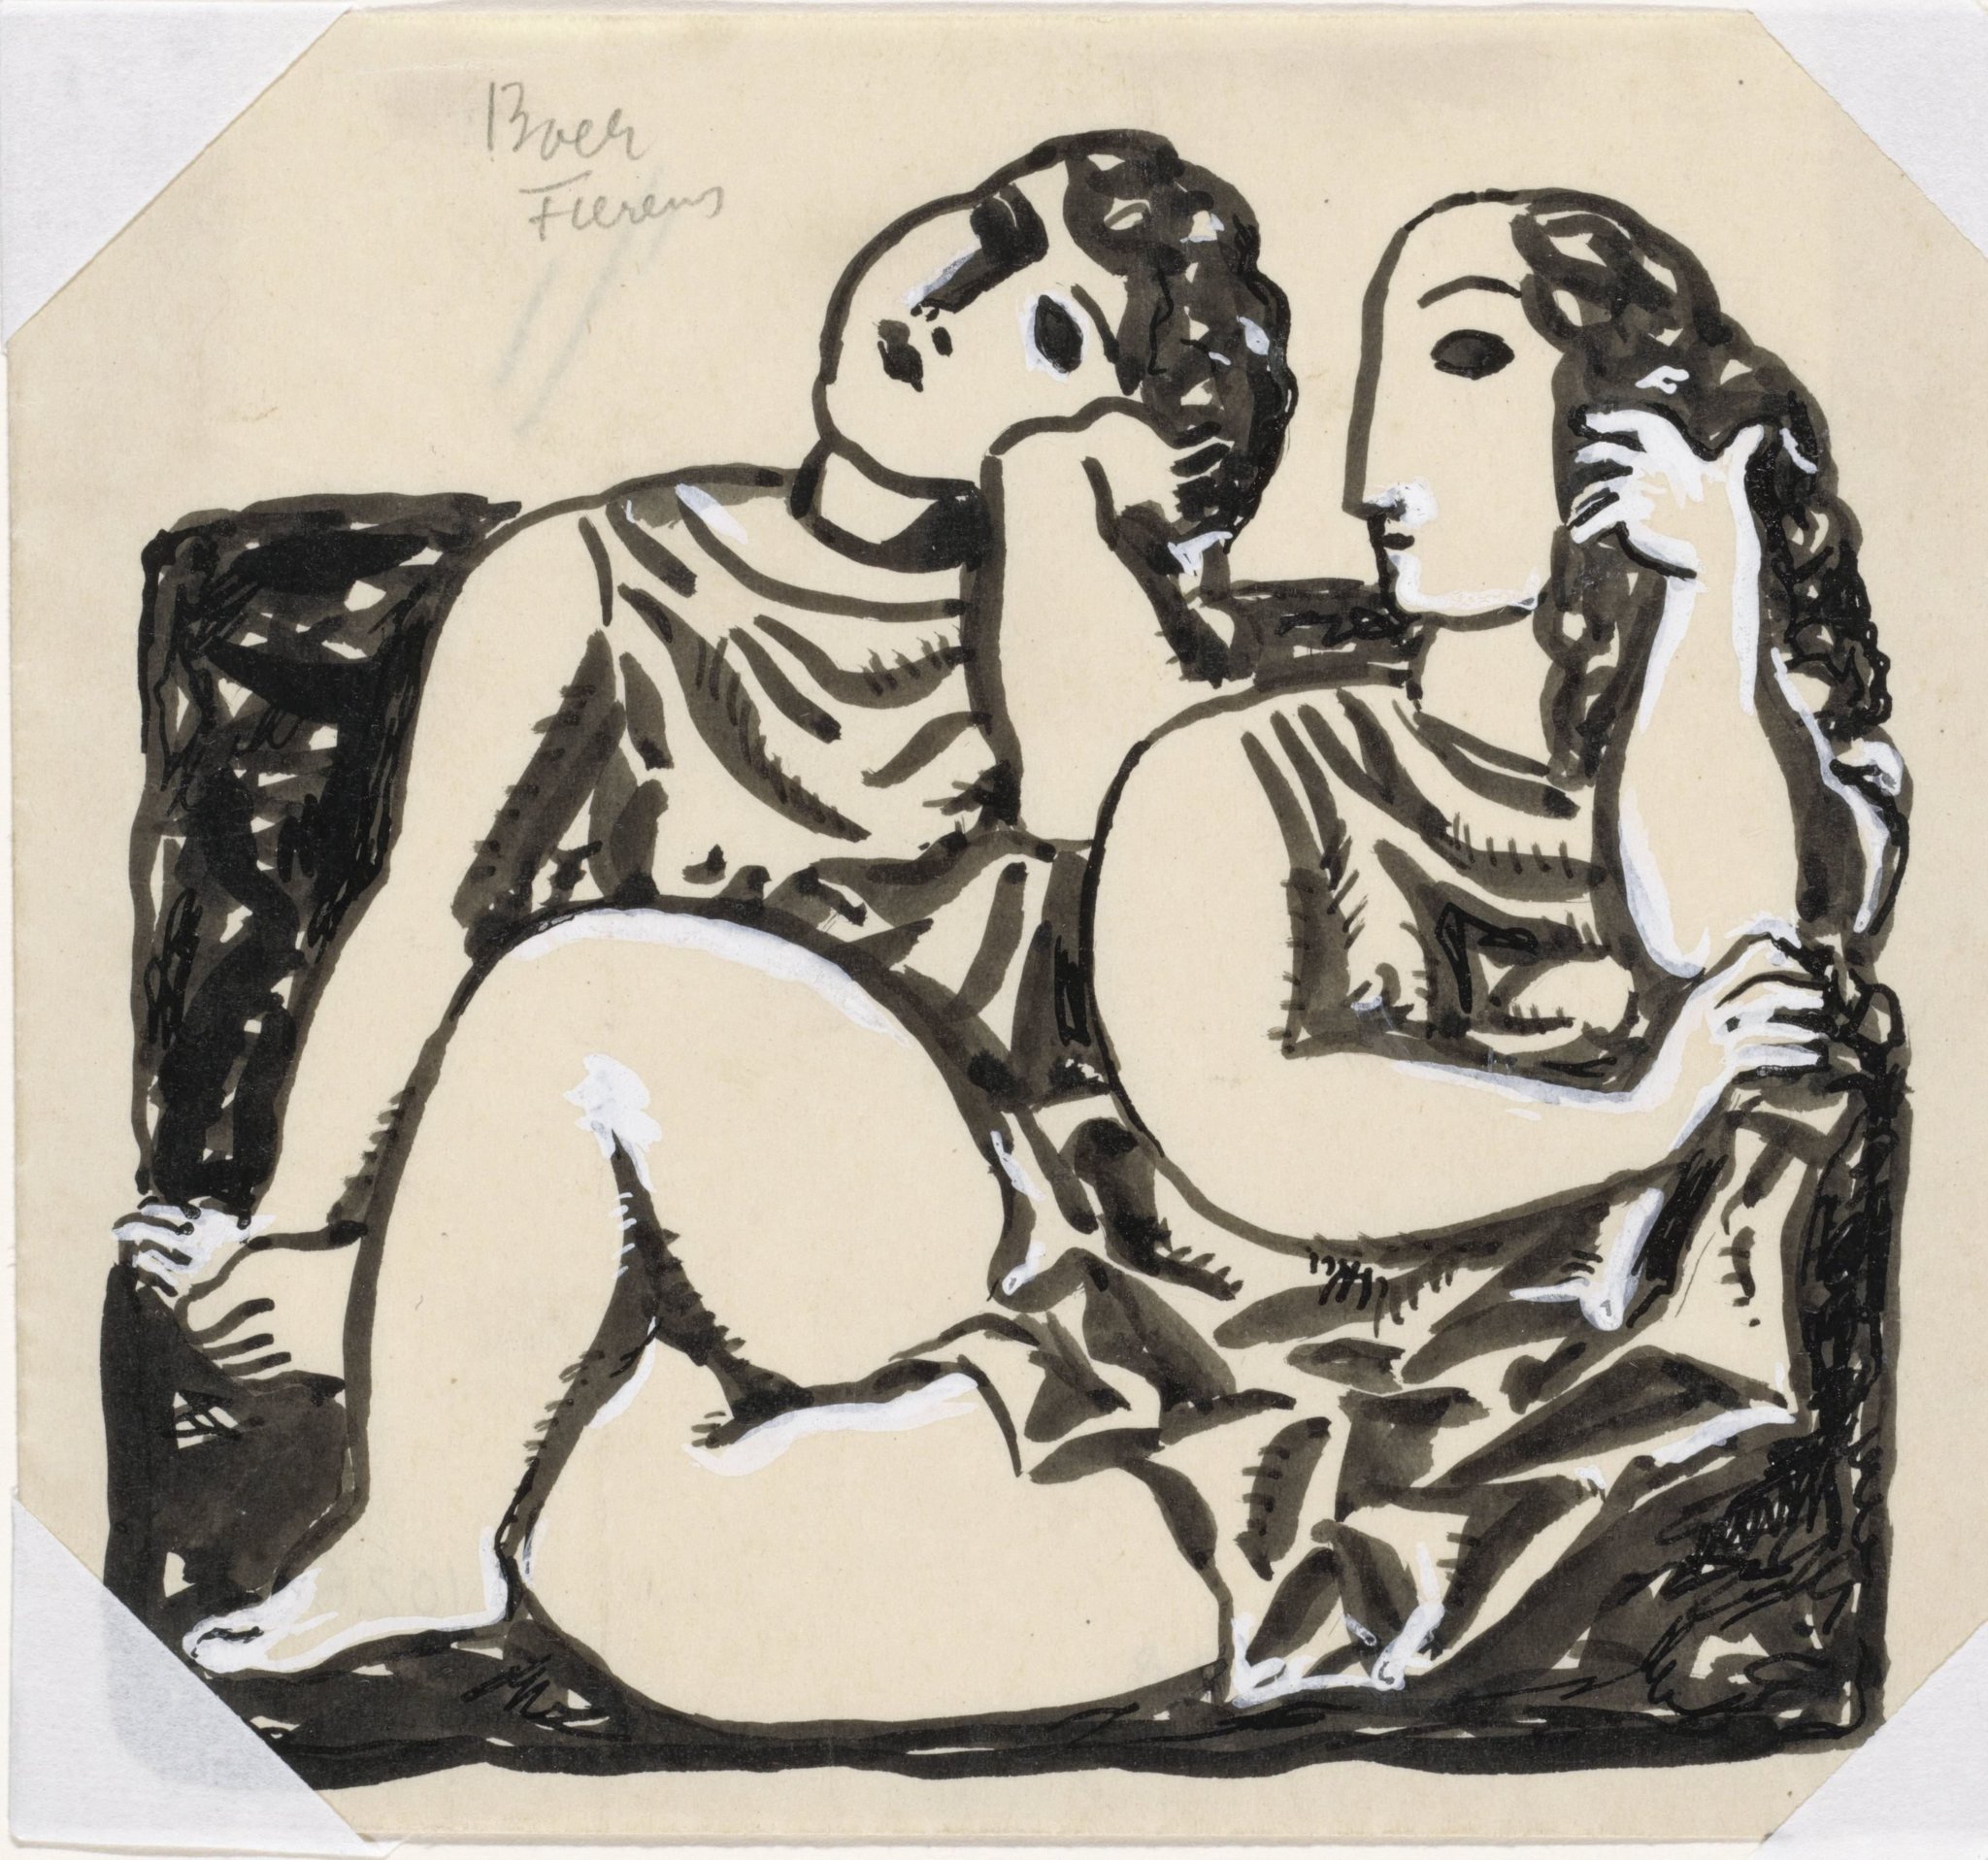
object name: drawing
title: Zonder titel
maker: leo gestel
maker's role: draughtsman, print maker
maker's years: 1881-1941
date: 1932-1933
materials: gouache, ink, paper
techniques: brush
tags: taking a bath, sitting figure - aa - female human figure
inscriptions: inscription: ‘boek Fierens’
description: Twee baadsters met zwart ingevulde ogen en geplooide tunieken, de handen bij de slaap. Enkele witte hoogsels, zoals bij de armen en benen.